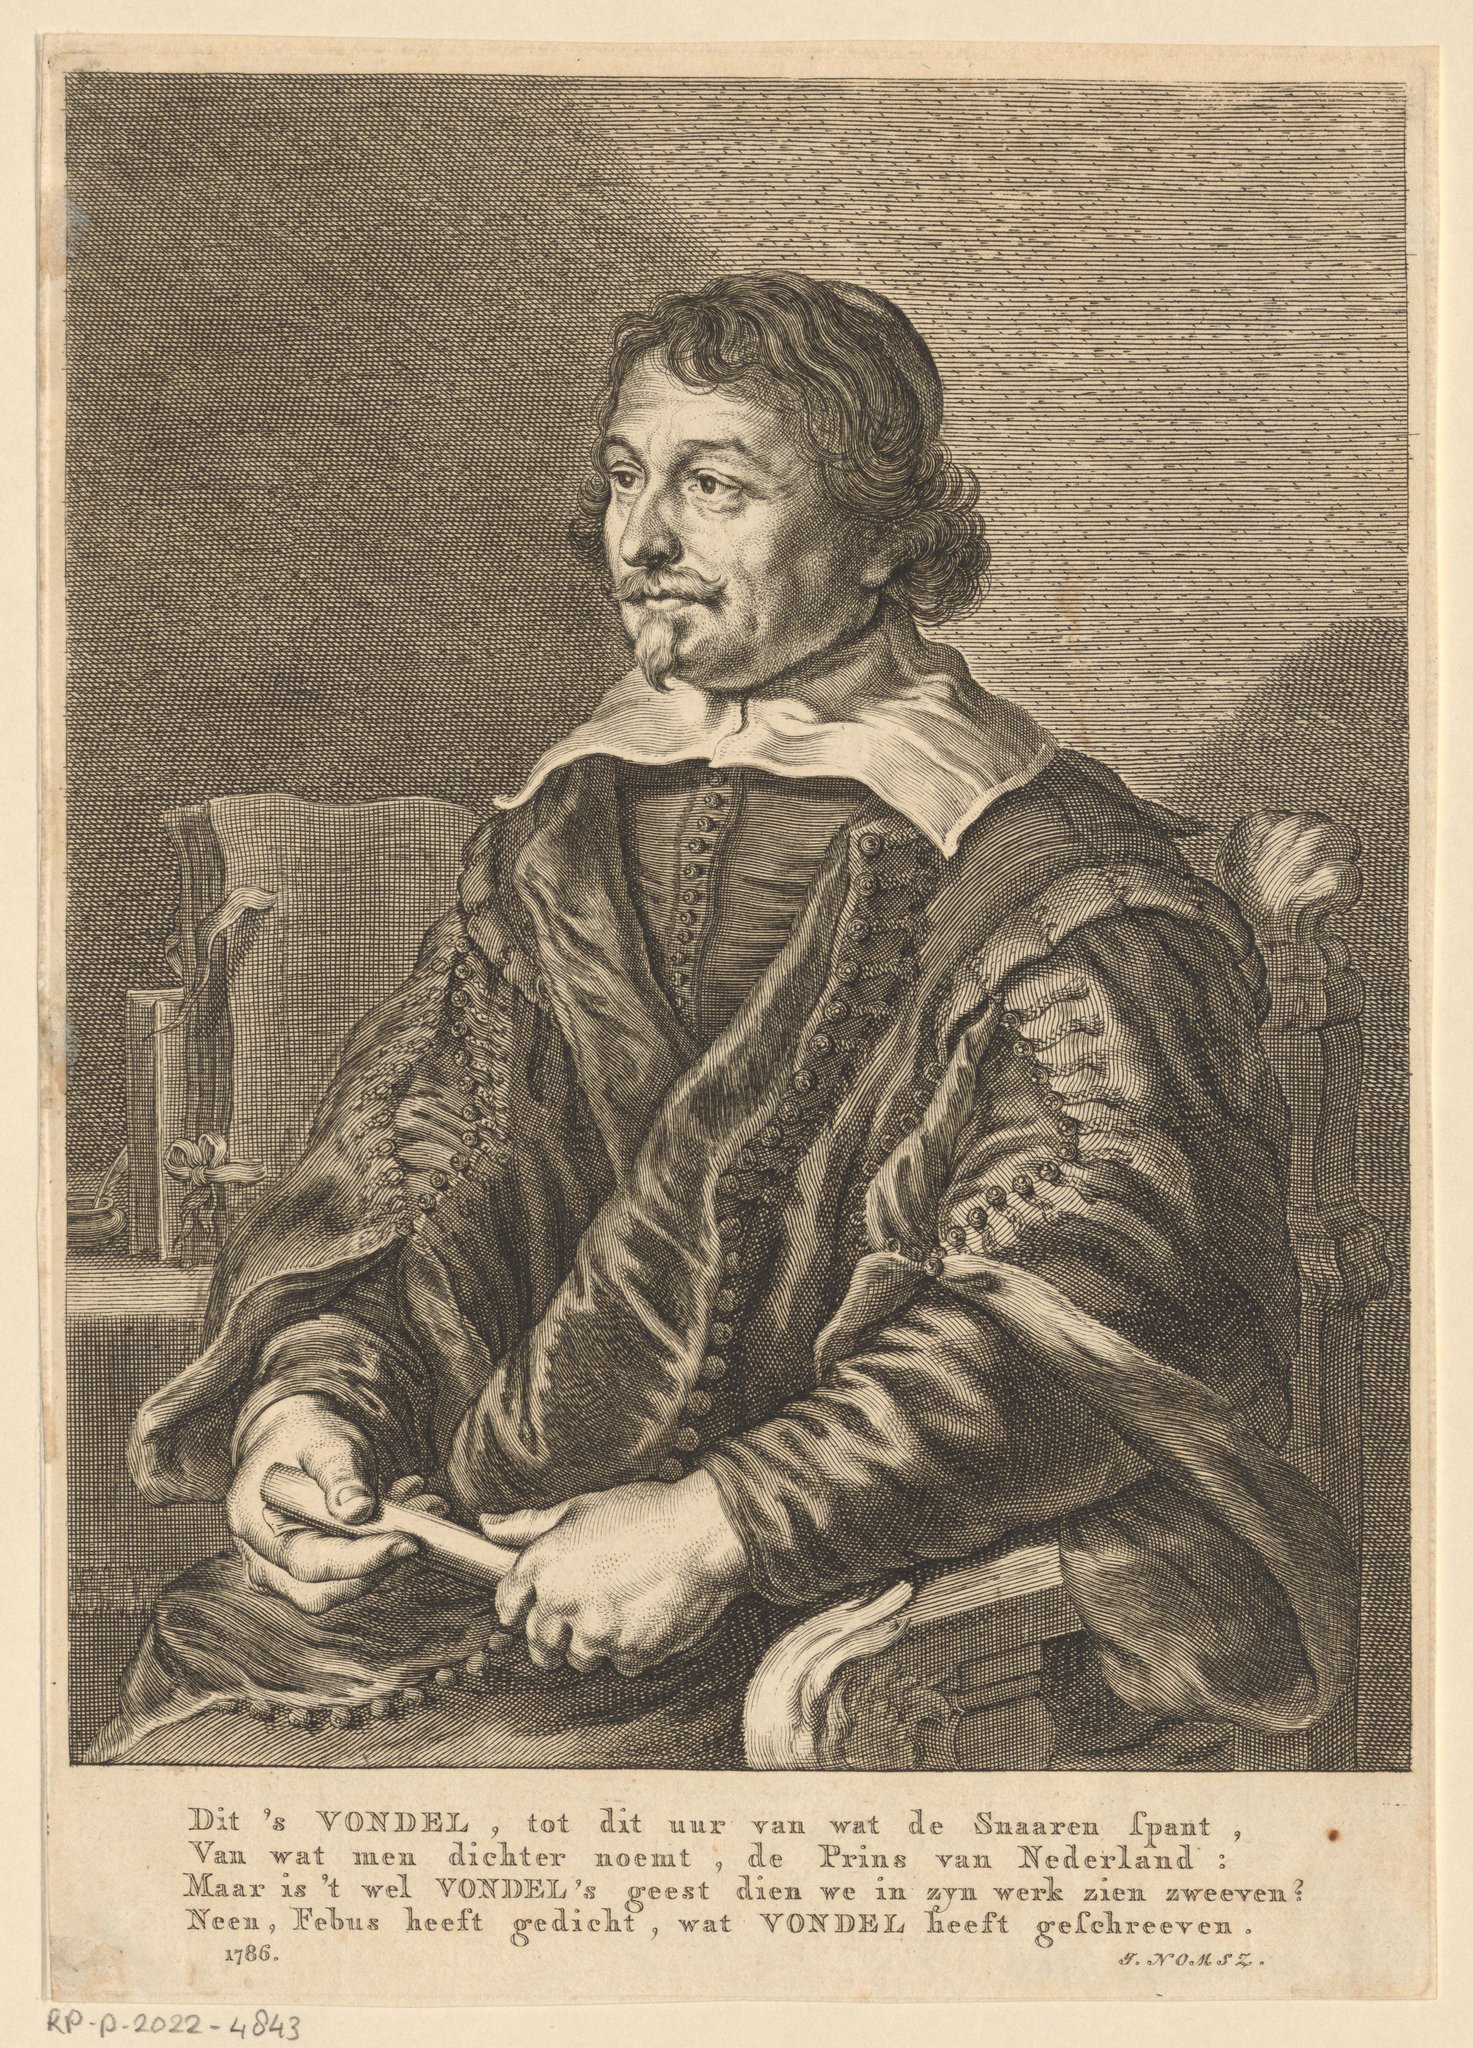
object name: print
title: Portret van Joost van den Vondel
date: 1786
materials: paper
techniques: engraving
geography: northern netherlands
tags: cologne, joost van den vondel, historical persons, portrait of a writer, writer, poet, author